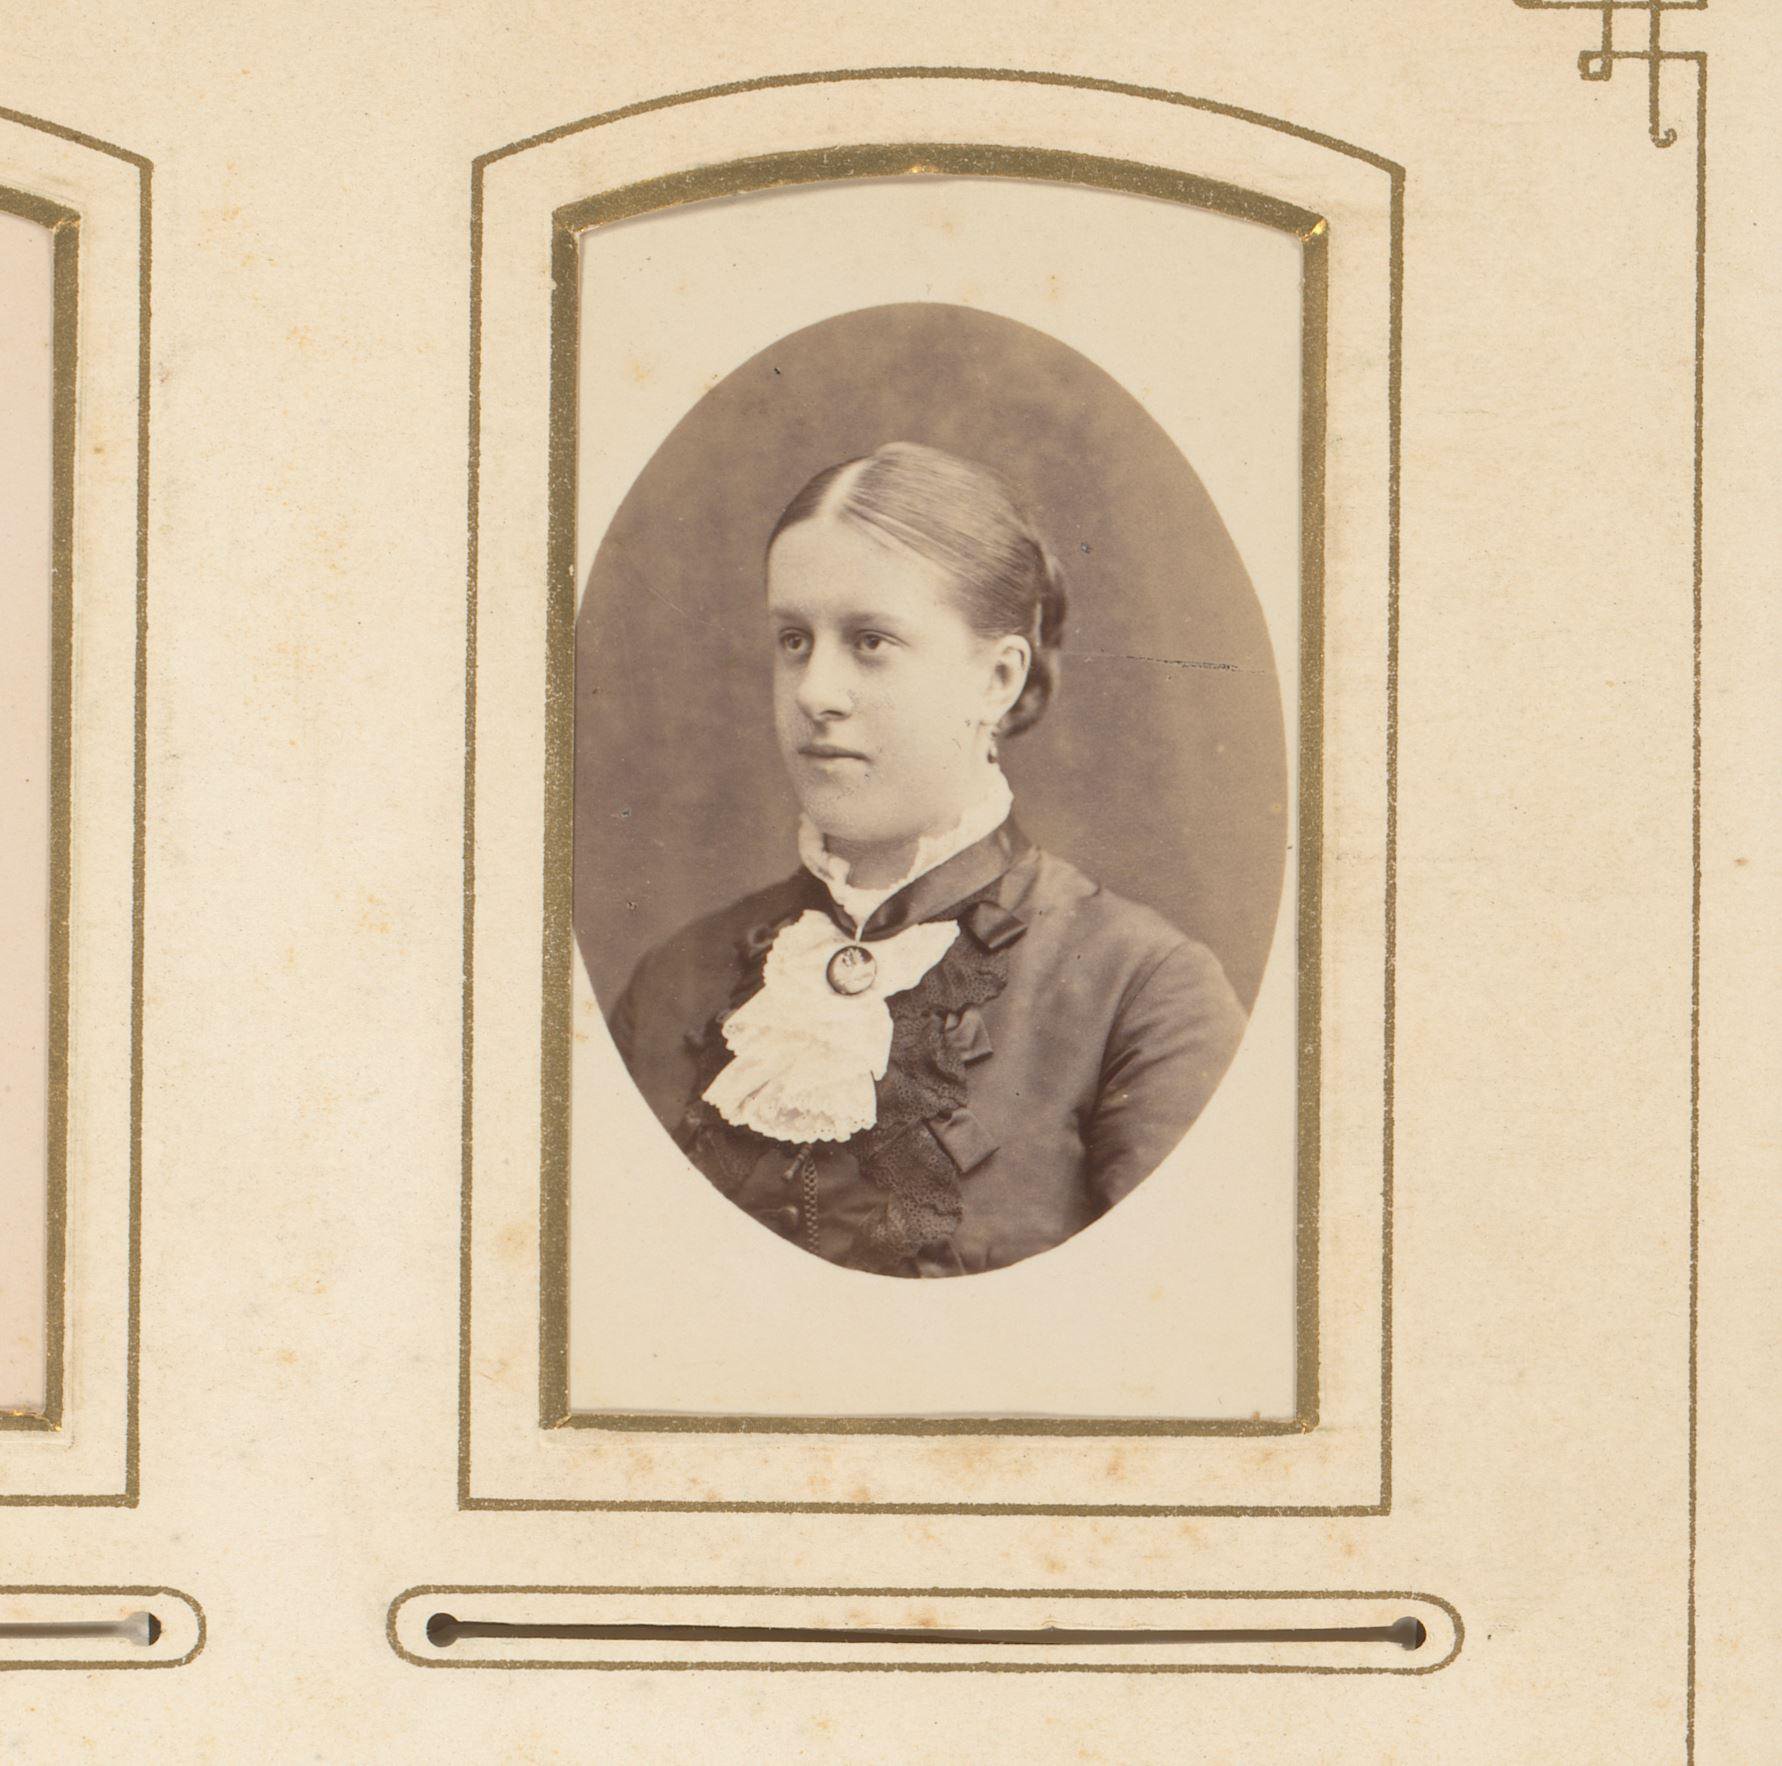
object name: carte de visite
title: Portret van een jonge vrouw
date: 1865-1903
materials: cardboard, photographic support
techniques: albumen print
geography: the hague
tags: adolescent, young woman, maiden, historical persons - bb - woman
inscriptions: inscription: ‘De Lavieter & Co/ PHOTOGRAPHES DE S. M. LE ROI/ ET SON ALTESSE ROYALE/ LE PRINCE ALEXANDRE/ DES PAYS-BAS./ LA HAYE.’